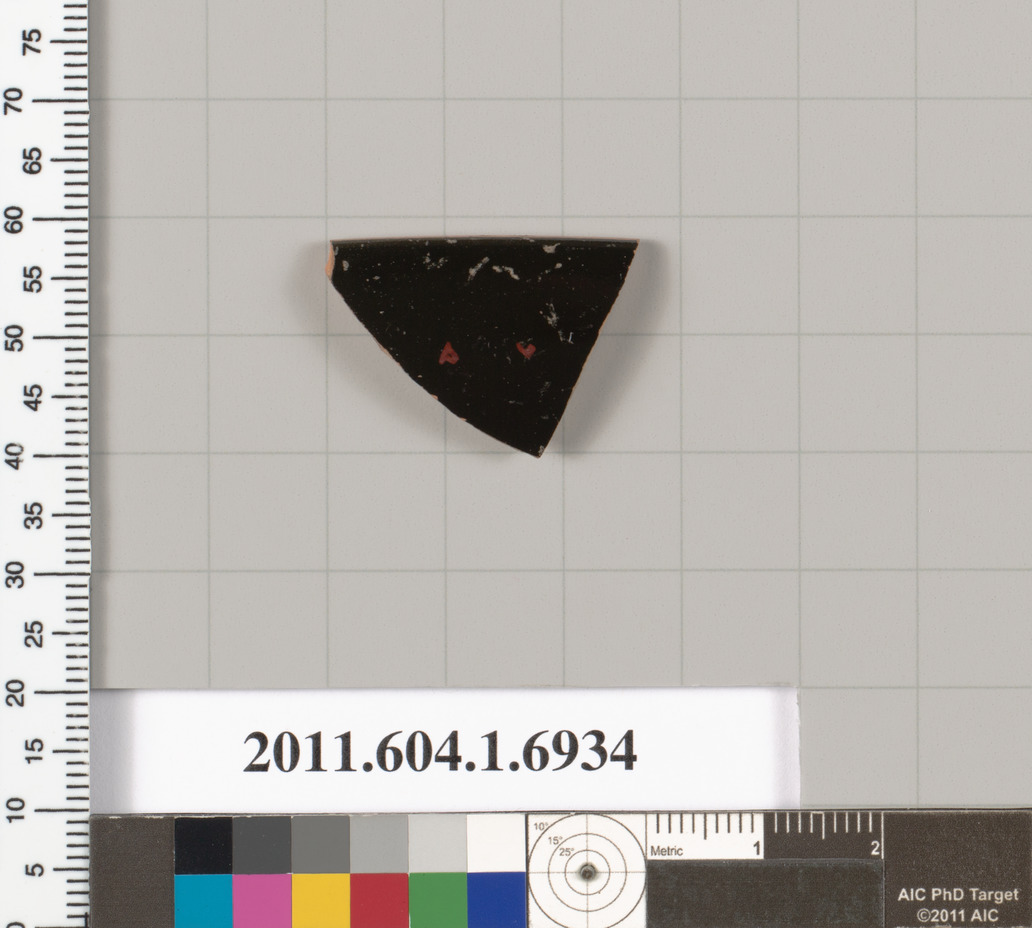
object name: kylix fragment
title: Terracotta rim fragment of a kylix (drinking cup)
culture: greek, attic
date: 490-470 BCE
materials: terracotta